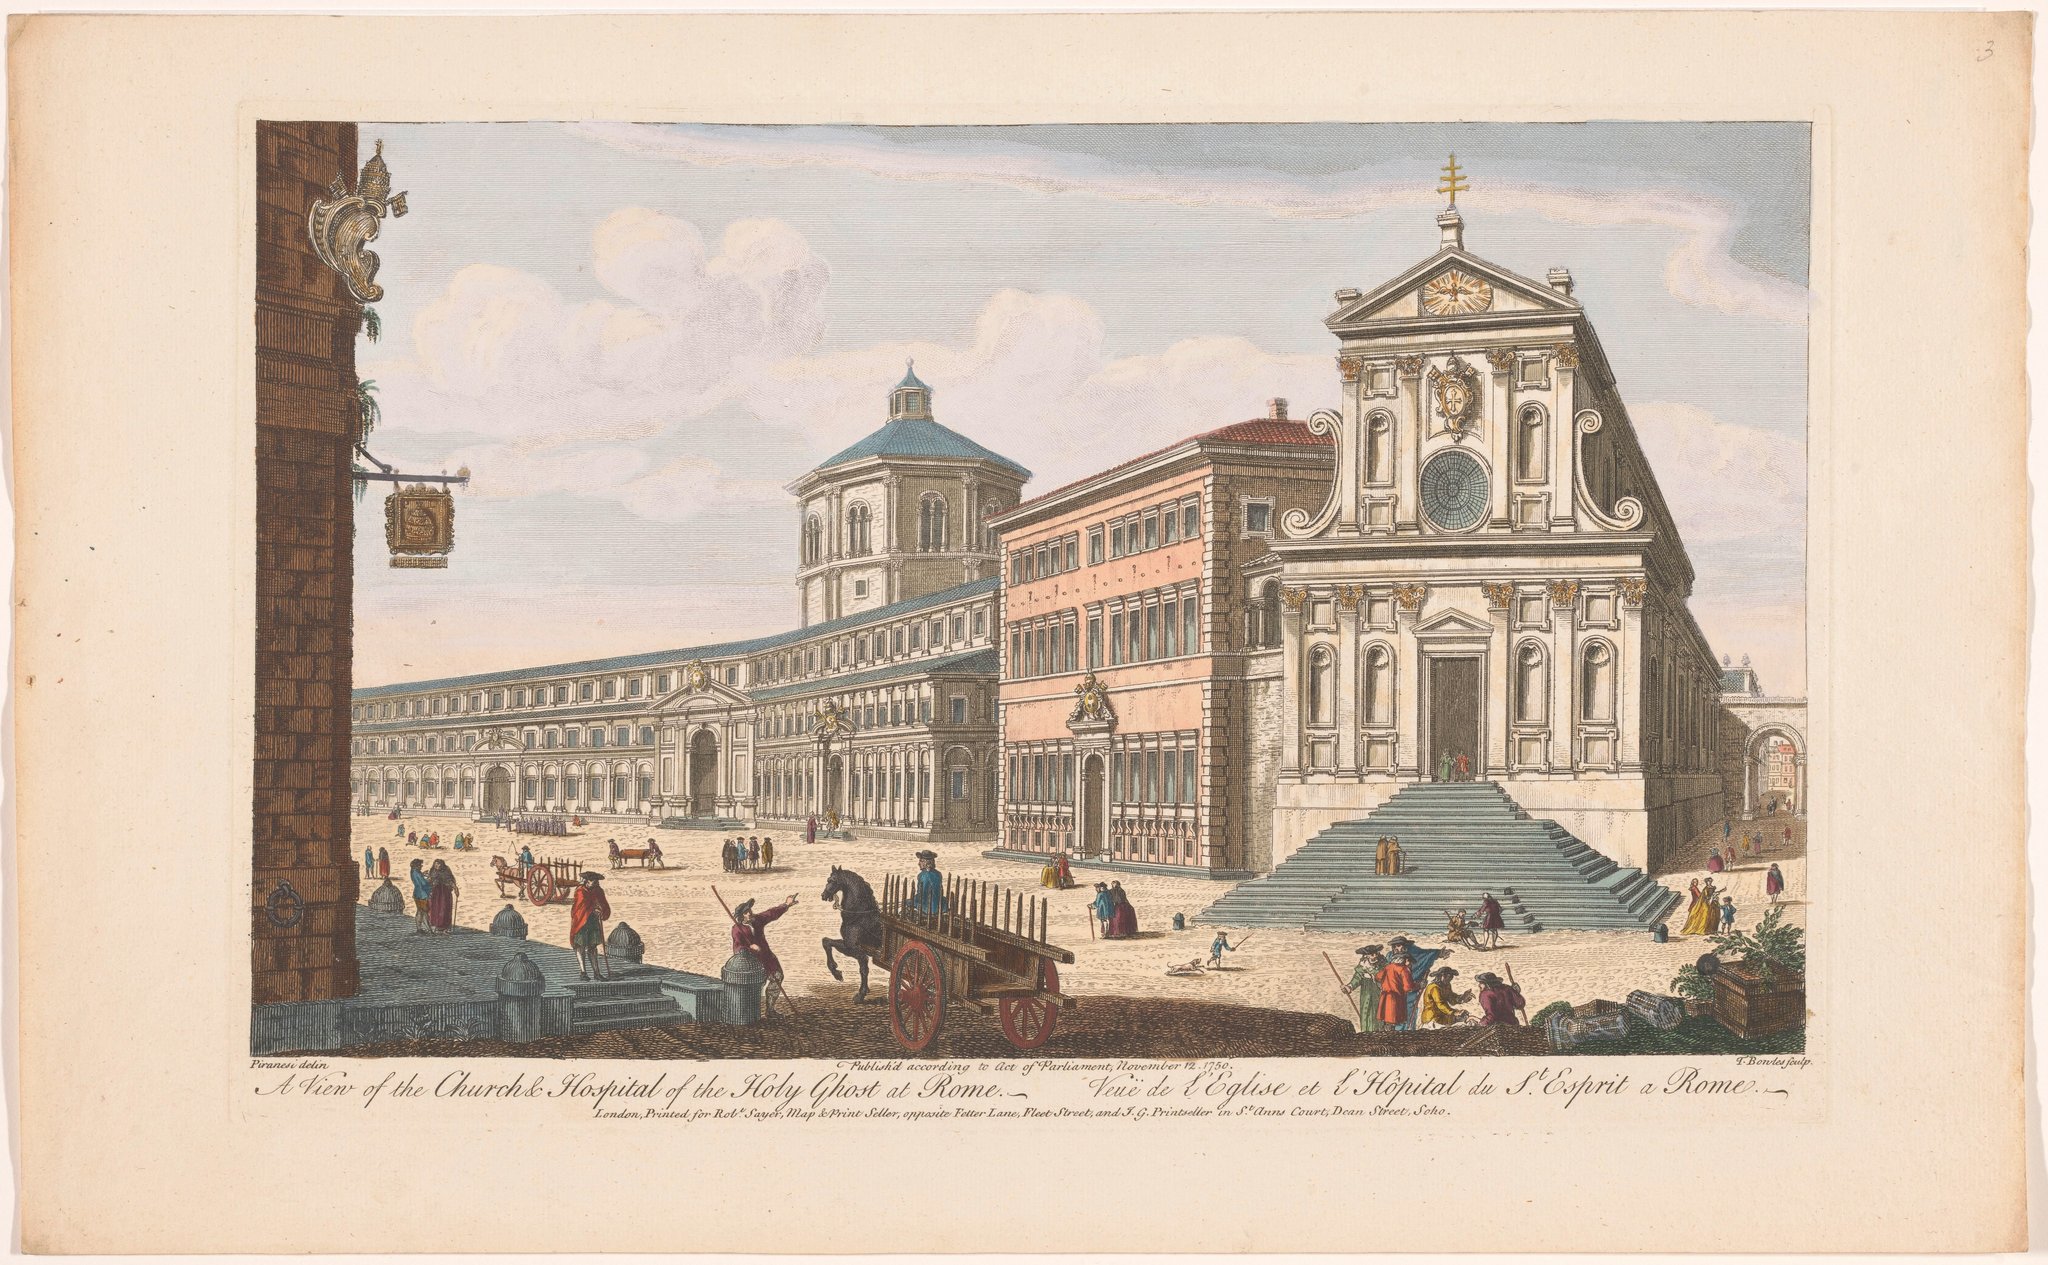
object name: opticaprent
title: A view of the Church & Hospital of the Holy Ghost at Rome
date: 1750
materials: paper, watercolor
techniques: brush, etching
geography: london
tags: church (exterior), street (+ city(-scape) with figures, staffage)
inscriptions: date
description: De serie “Rome” bevat twaalf prenten met de nummers 1-12, waarvan dit nummer 3 is.